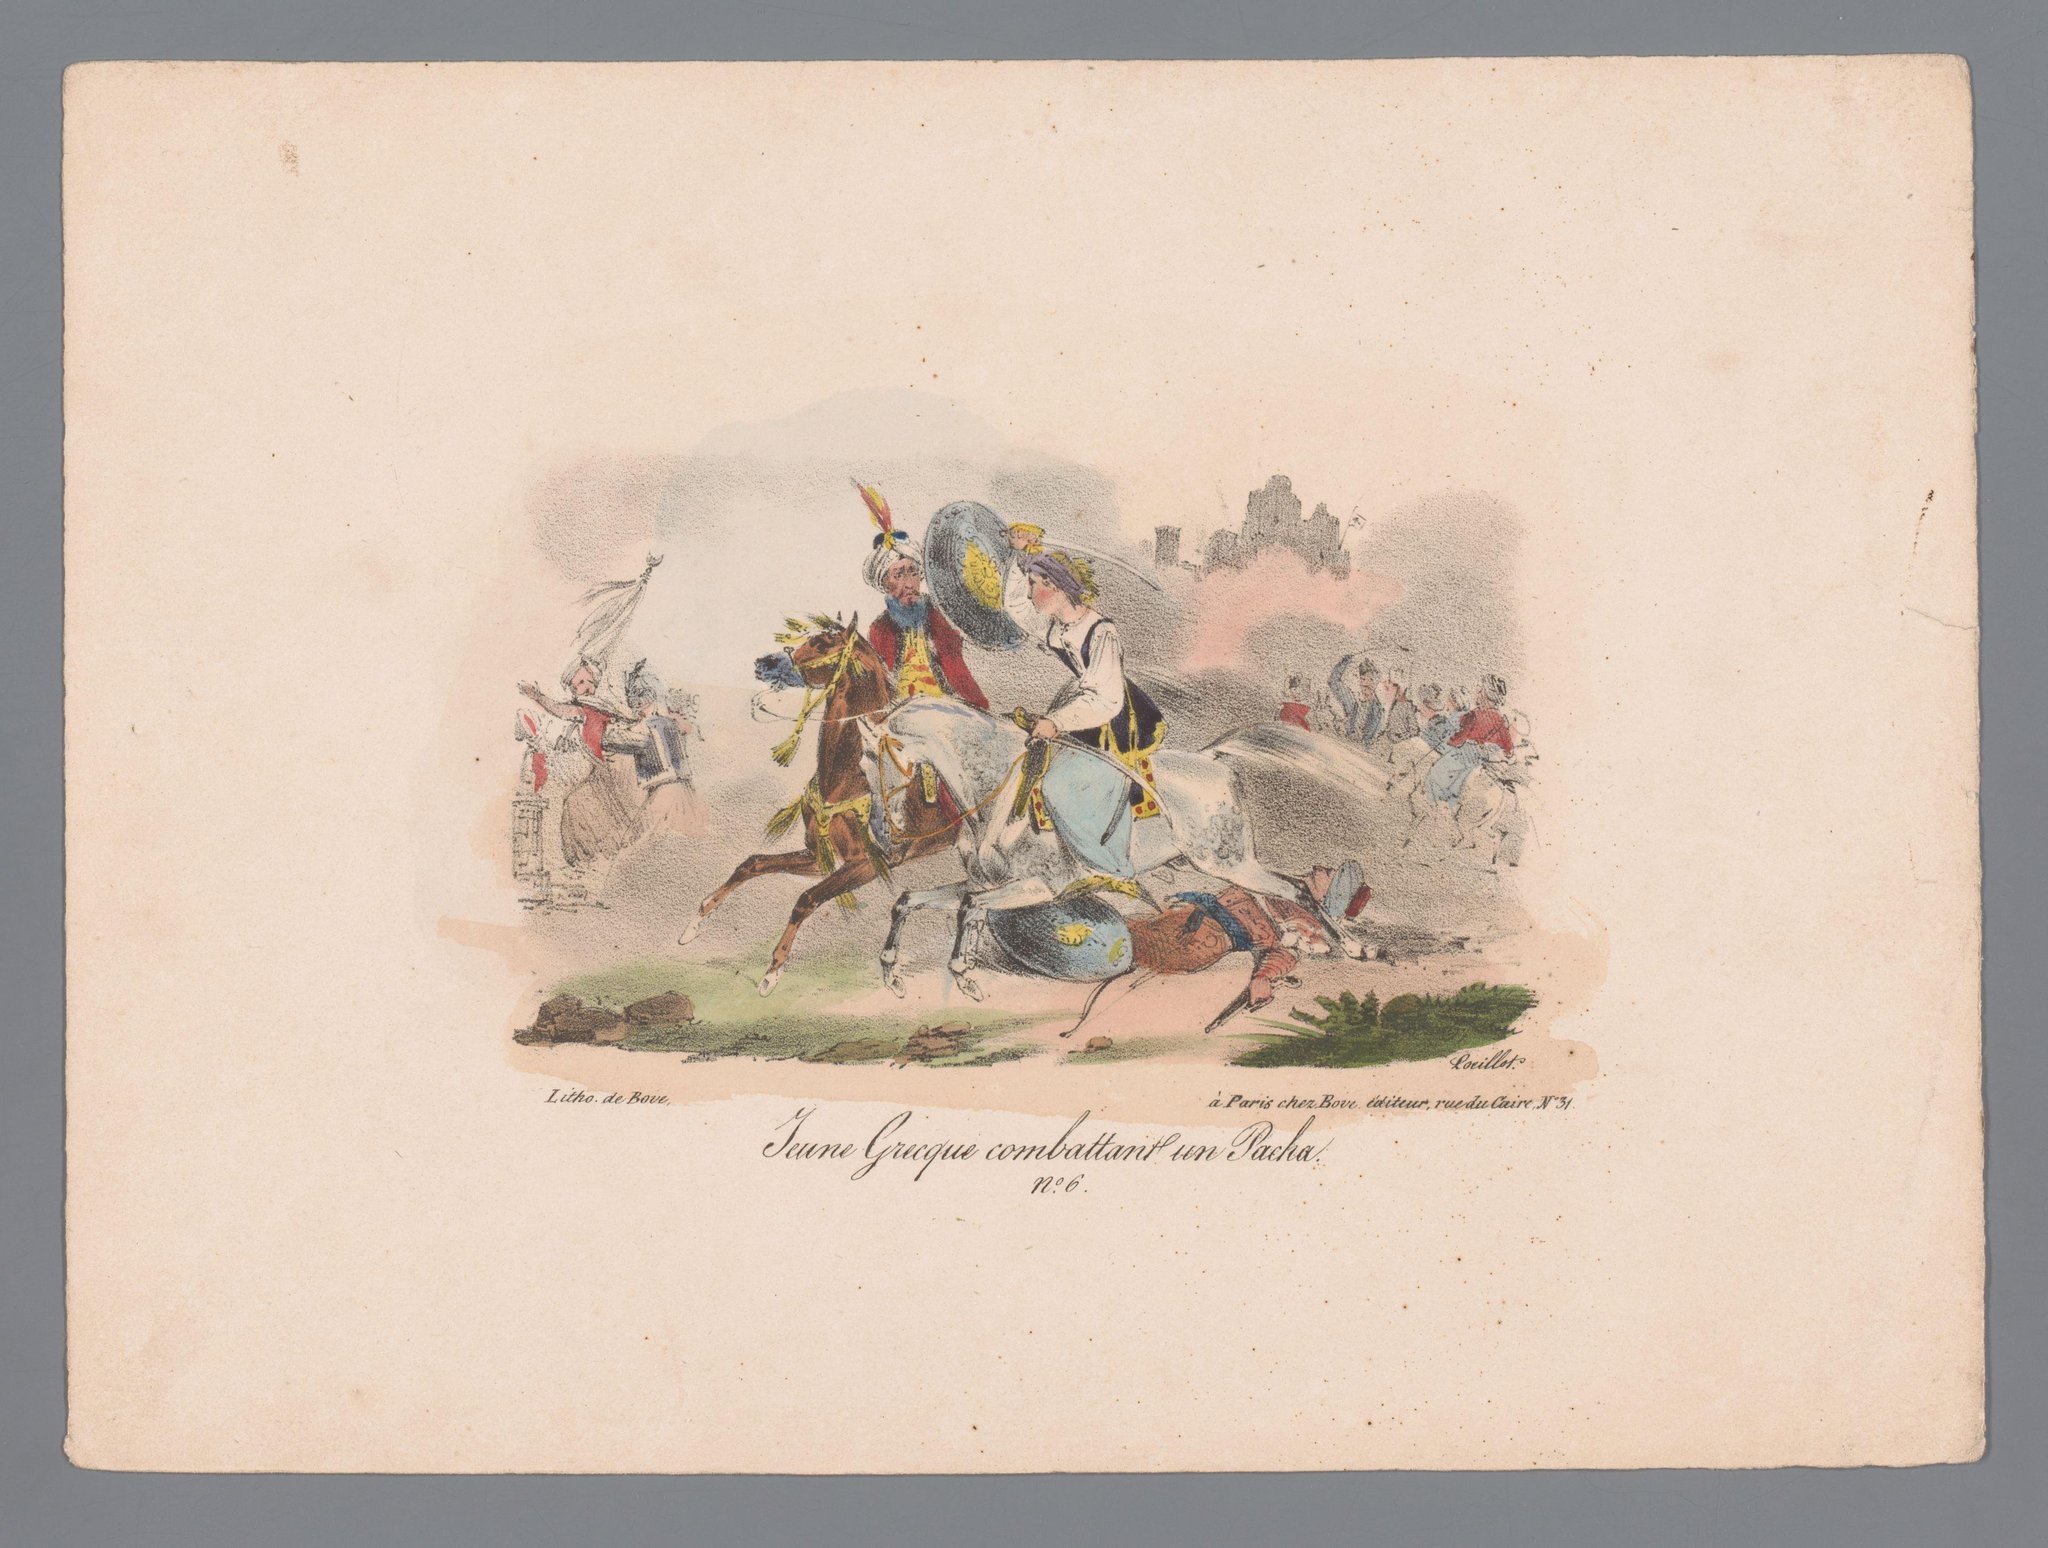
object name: print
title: Jonge Griek vecht tegen een pasja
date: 1829-1835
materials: paper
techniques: hand coloring, lithograph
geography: paris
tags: riding a horse, ass, or mule; rider, horseman, battle, fighting in general, (military) uniforms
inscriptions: collector's mark: Lugt 2228